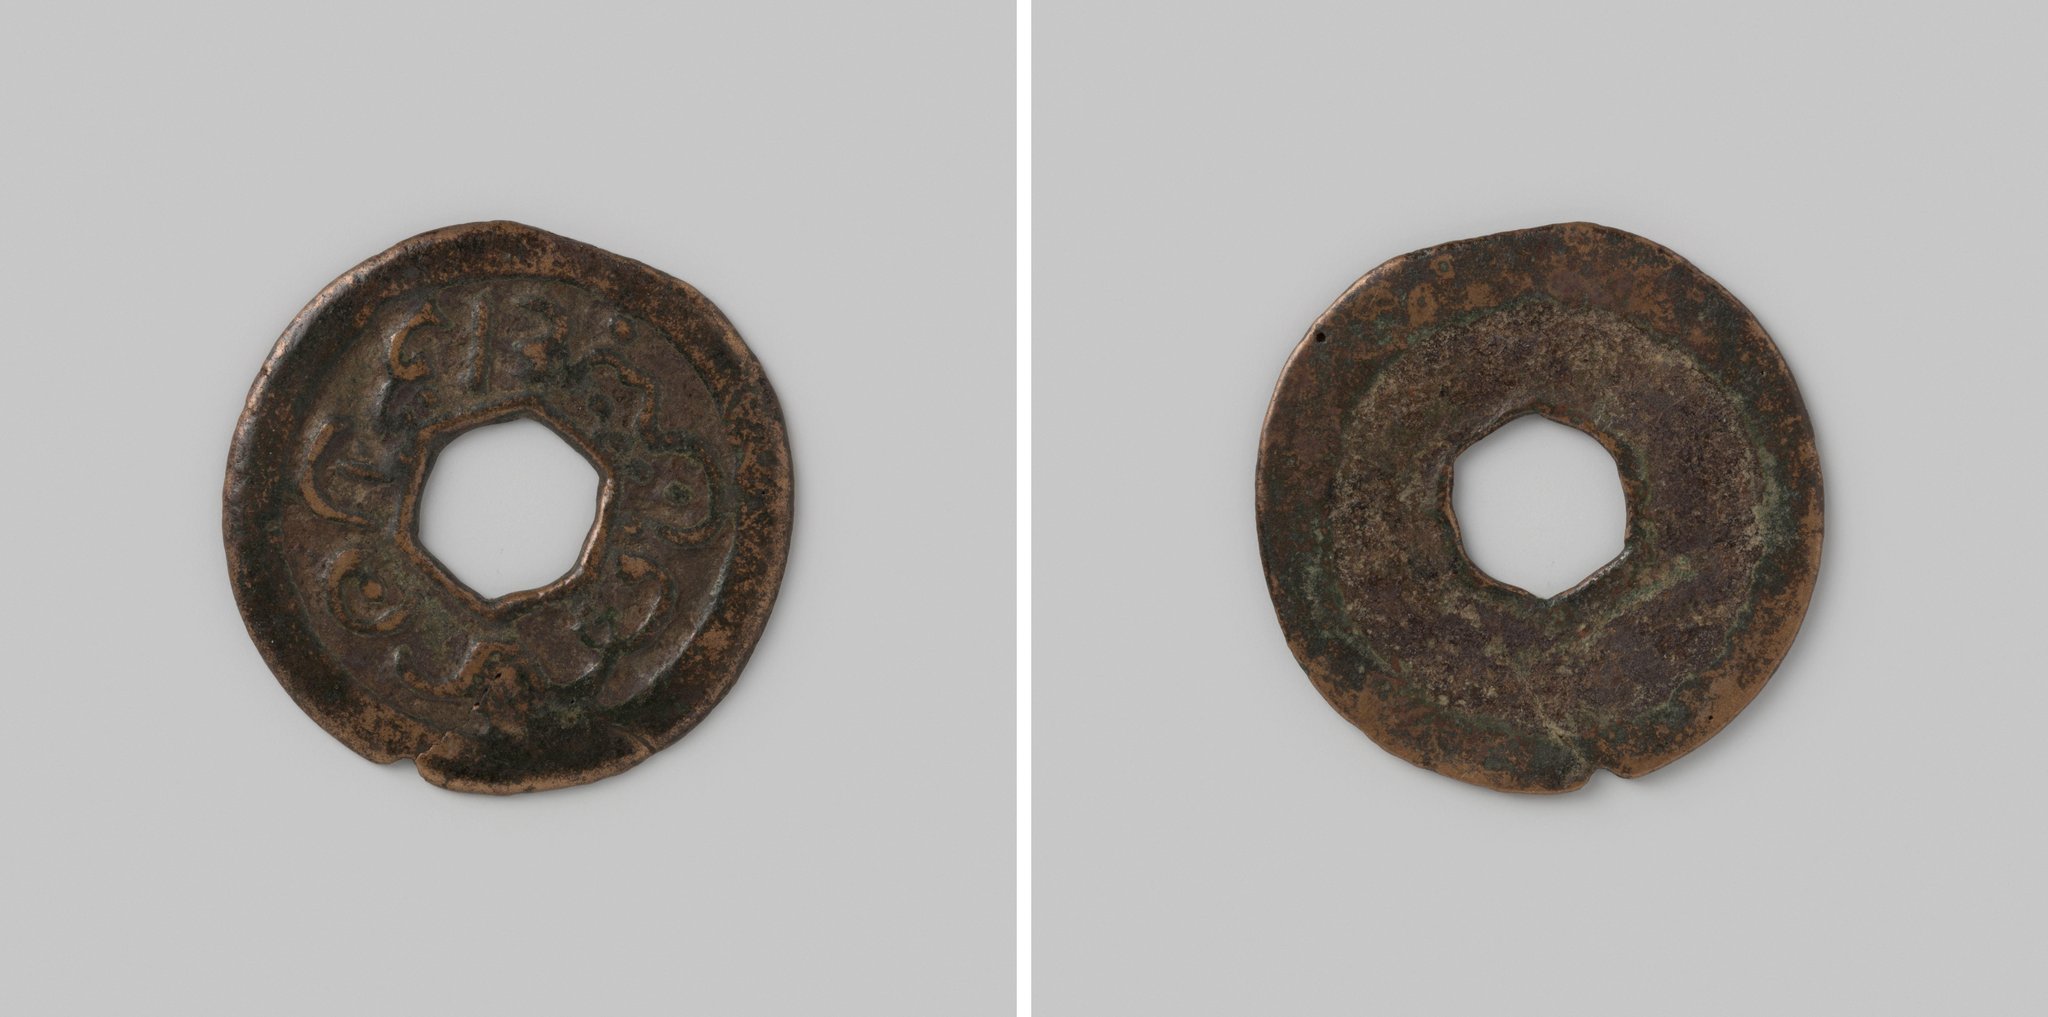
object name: coin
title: 2 pitjis uit Bantam, Java van Moelana Mohammed Sedo-ning Rana, 988-1005 [= 1580-1596] of van regent Pangeran aria Rana di Manggala, 1005-1016 [= 1596-1608]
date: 1580-1608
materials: copper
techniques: casting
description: Koperen munt. Voorzijde: binnen brede rand omschrift in Arabische lettertekens: pangeran ratu ing Bantan: heer vorst in Bantam. Keerzijde: binnen brede rand glad oppervlak. In het midden zeshoekig gat.